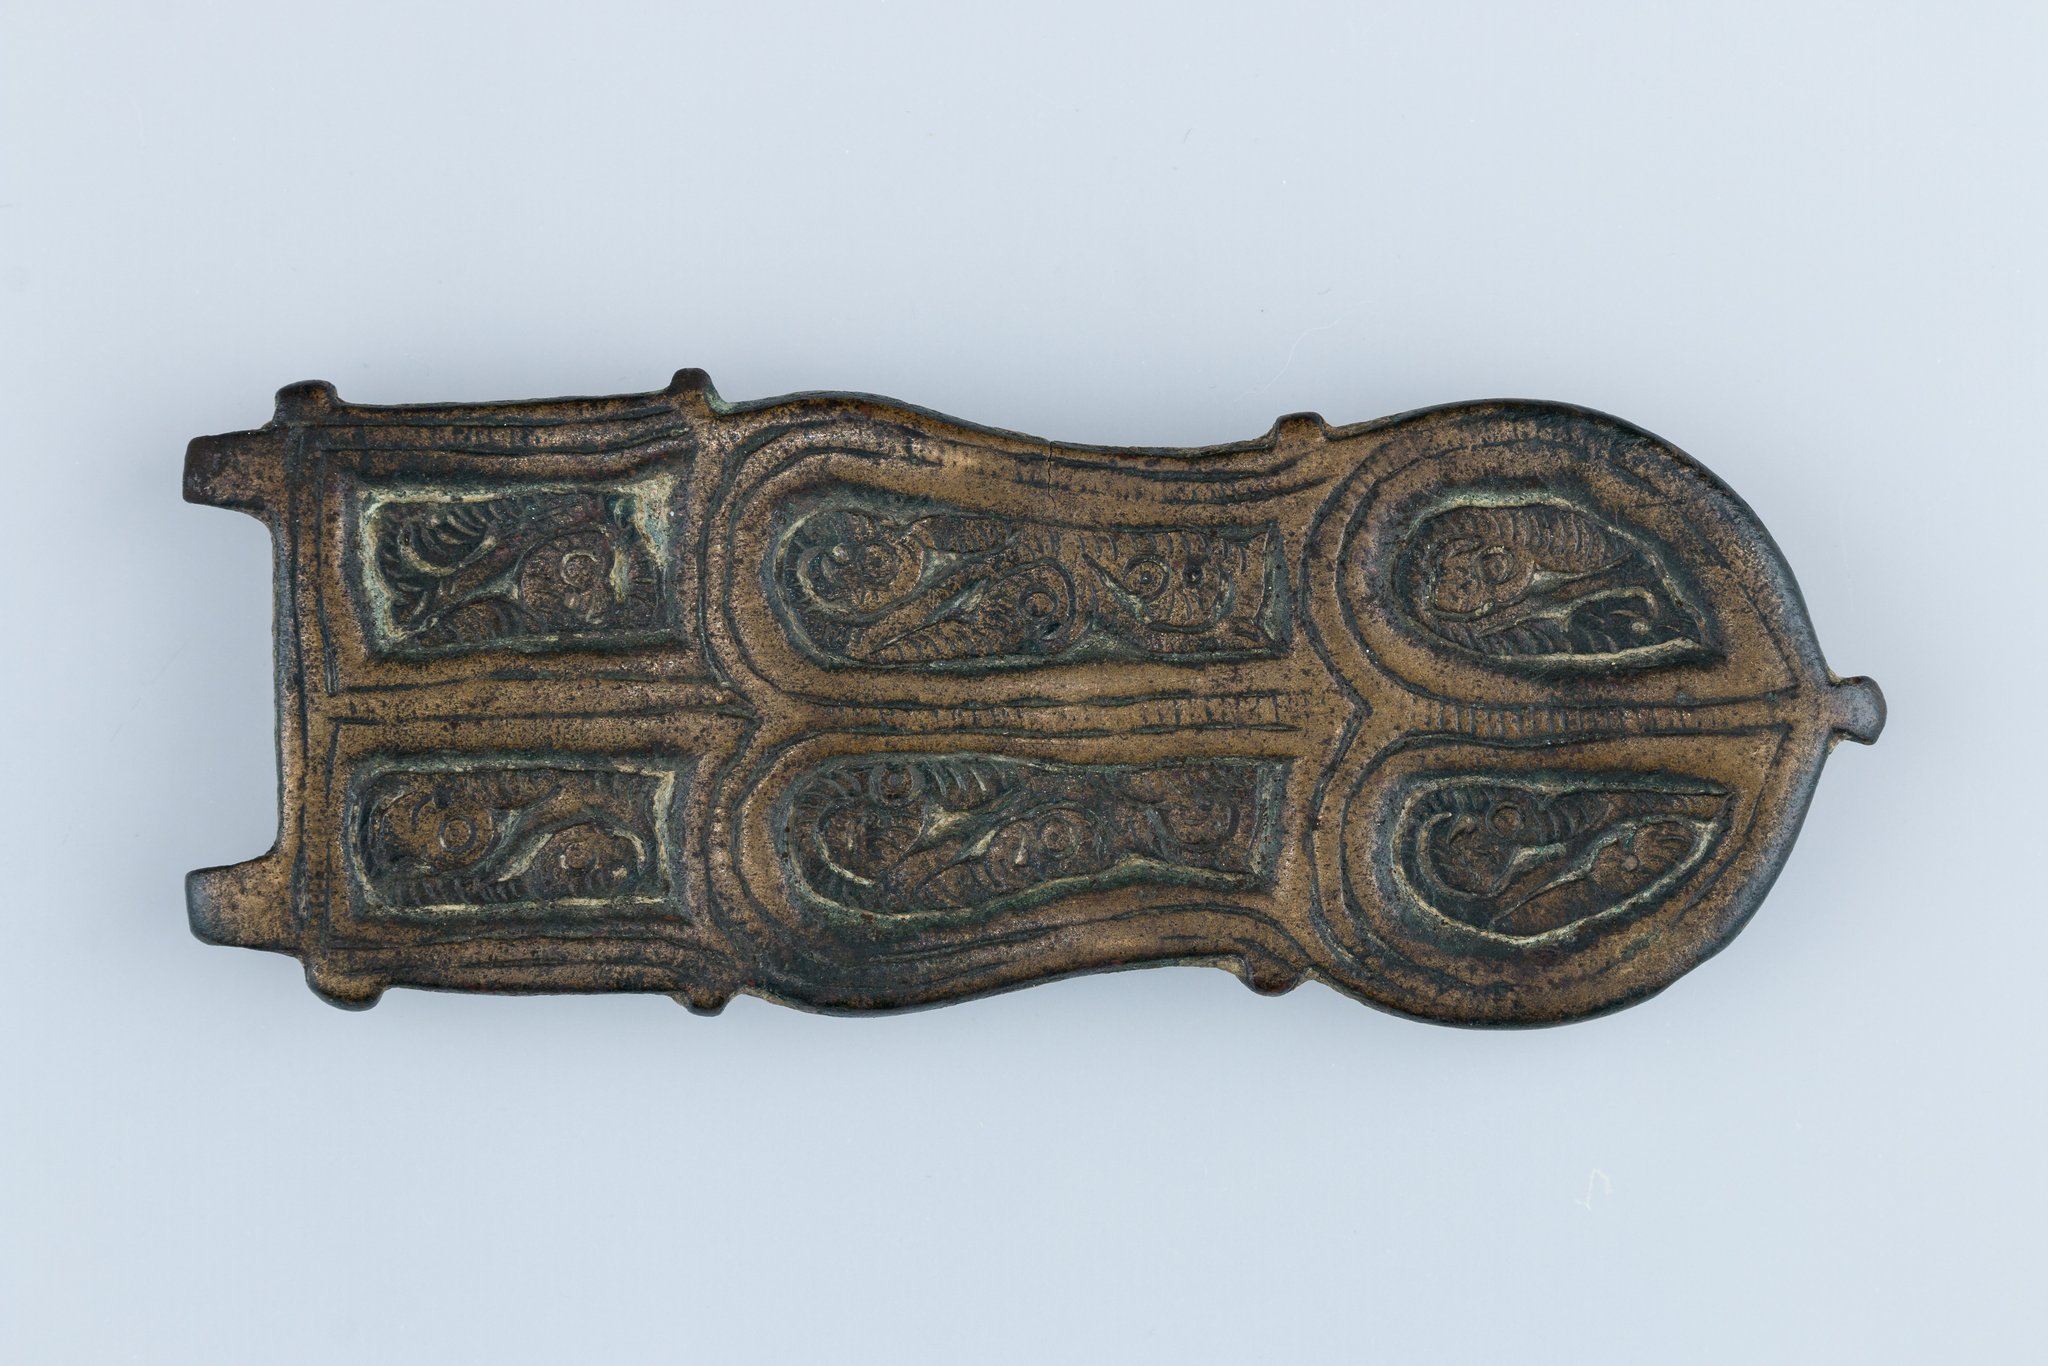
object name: buckle shank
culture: visigothic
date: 601-700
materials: copper alloy